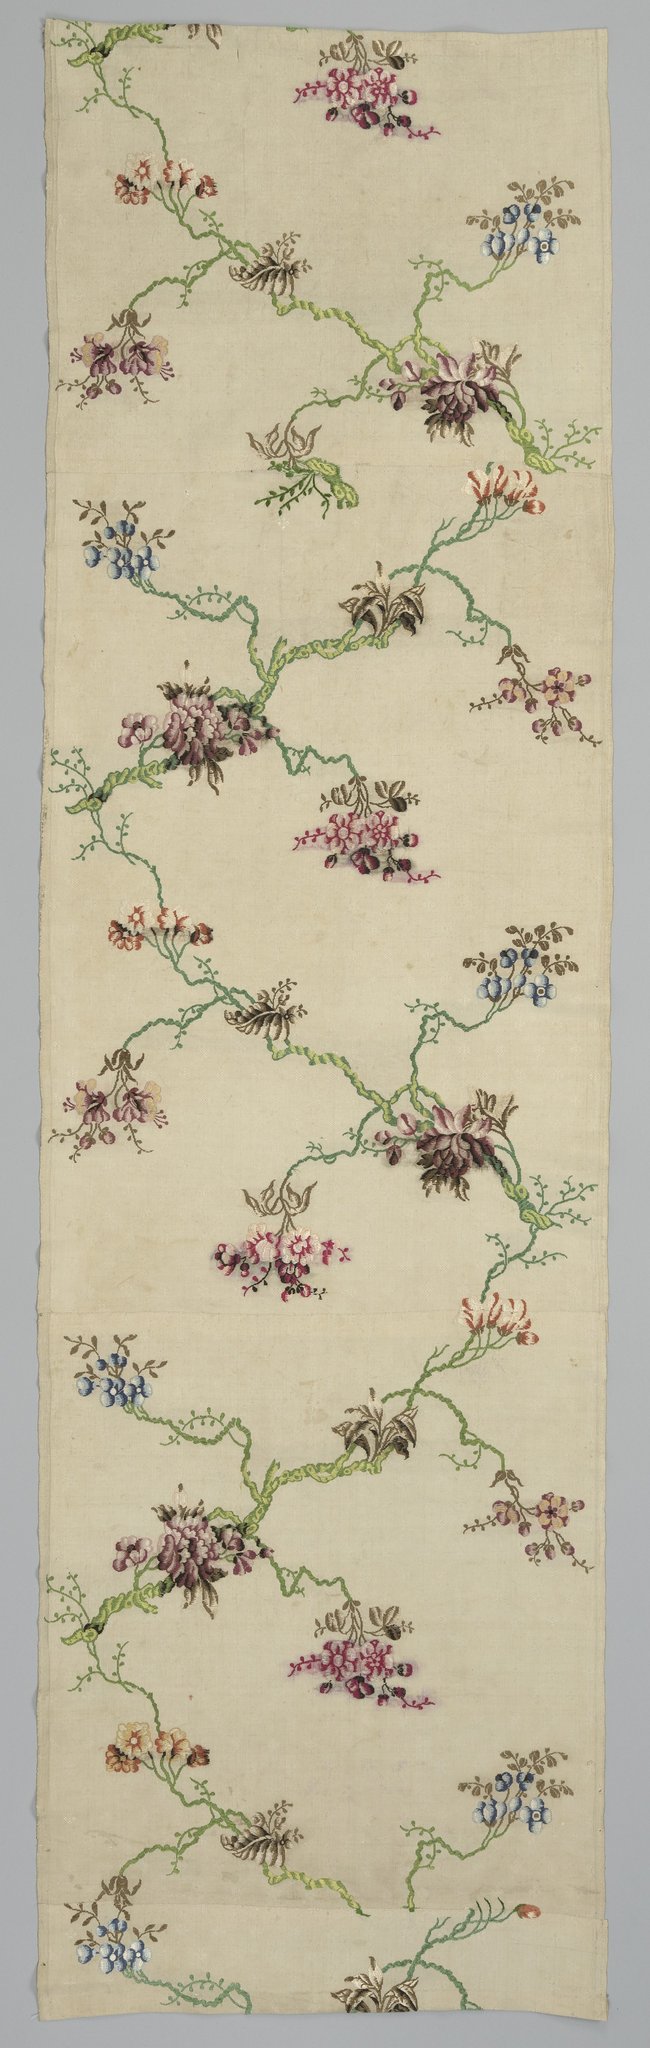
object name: length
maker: anna maria garthwaite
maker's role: designer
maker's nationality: british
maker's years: 1690-1763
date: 1748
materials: silk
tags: flowers